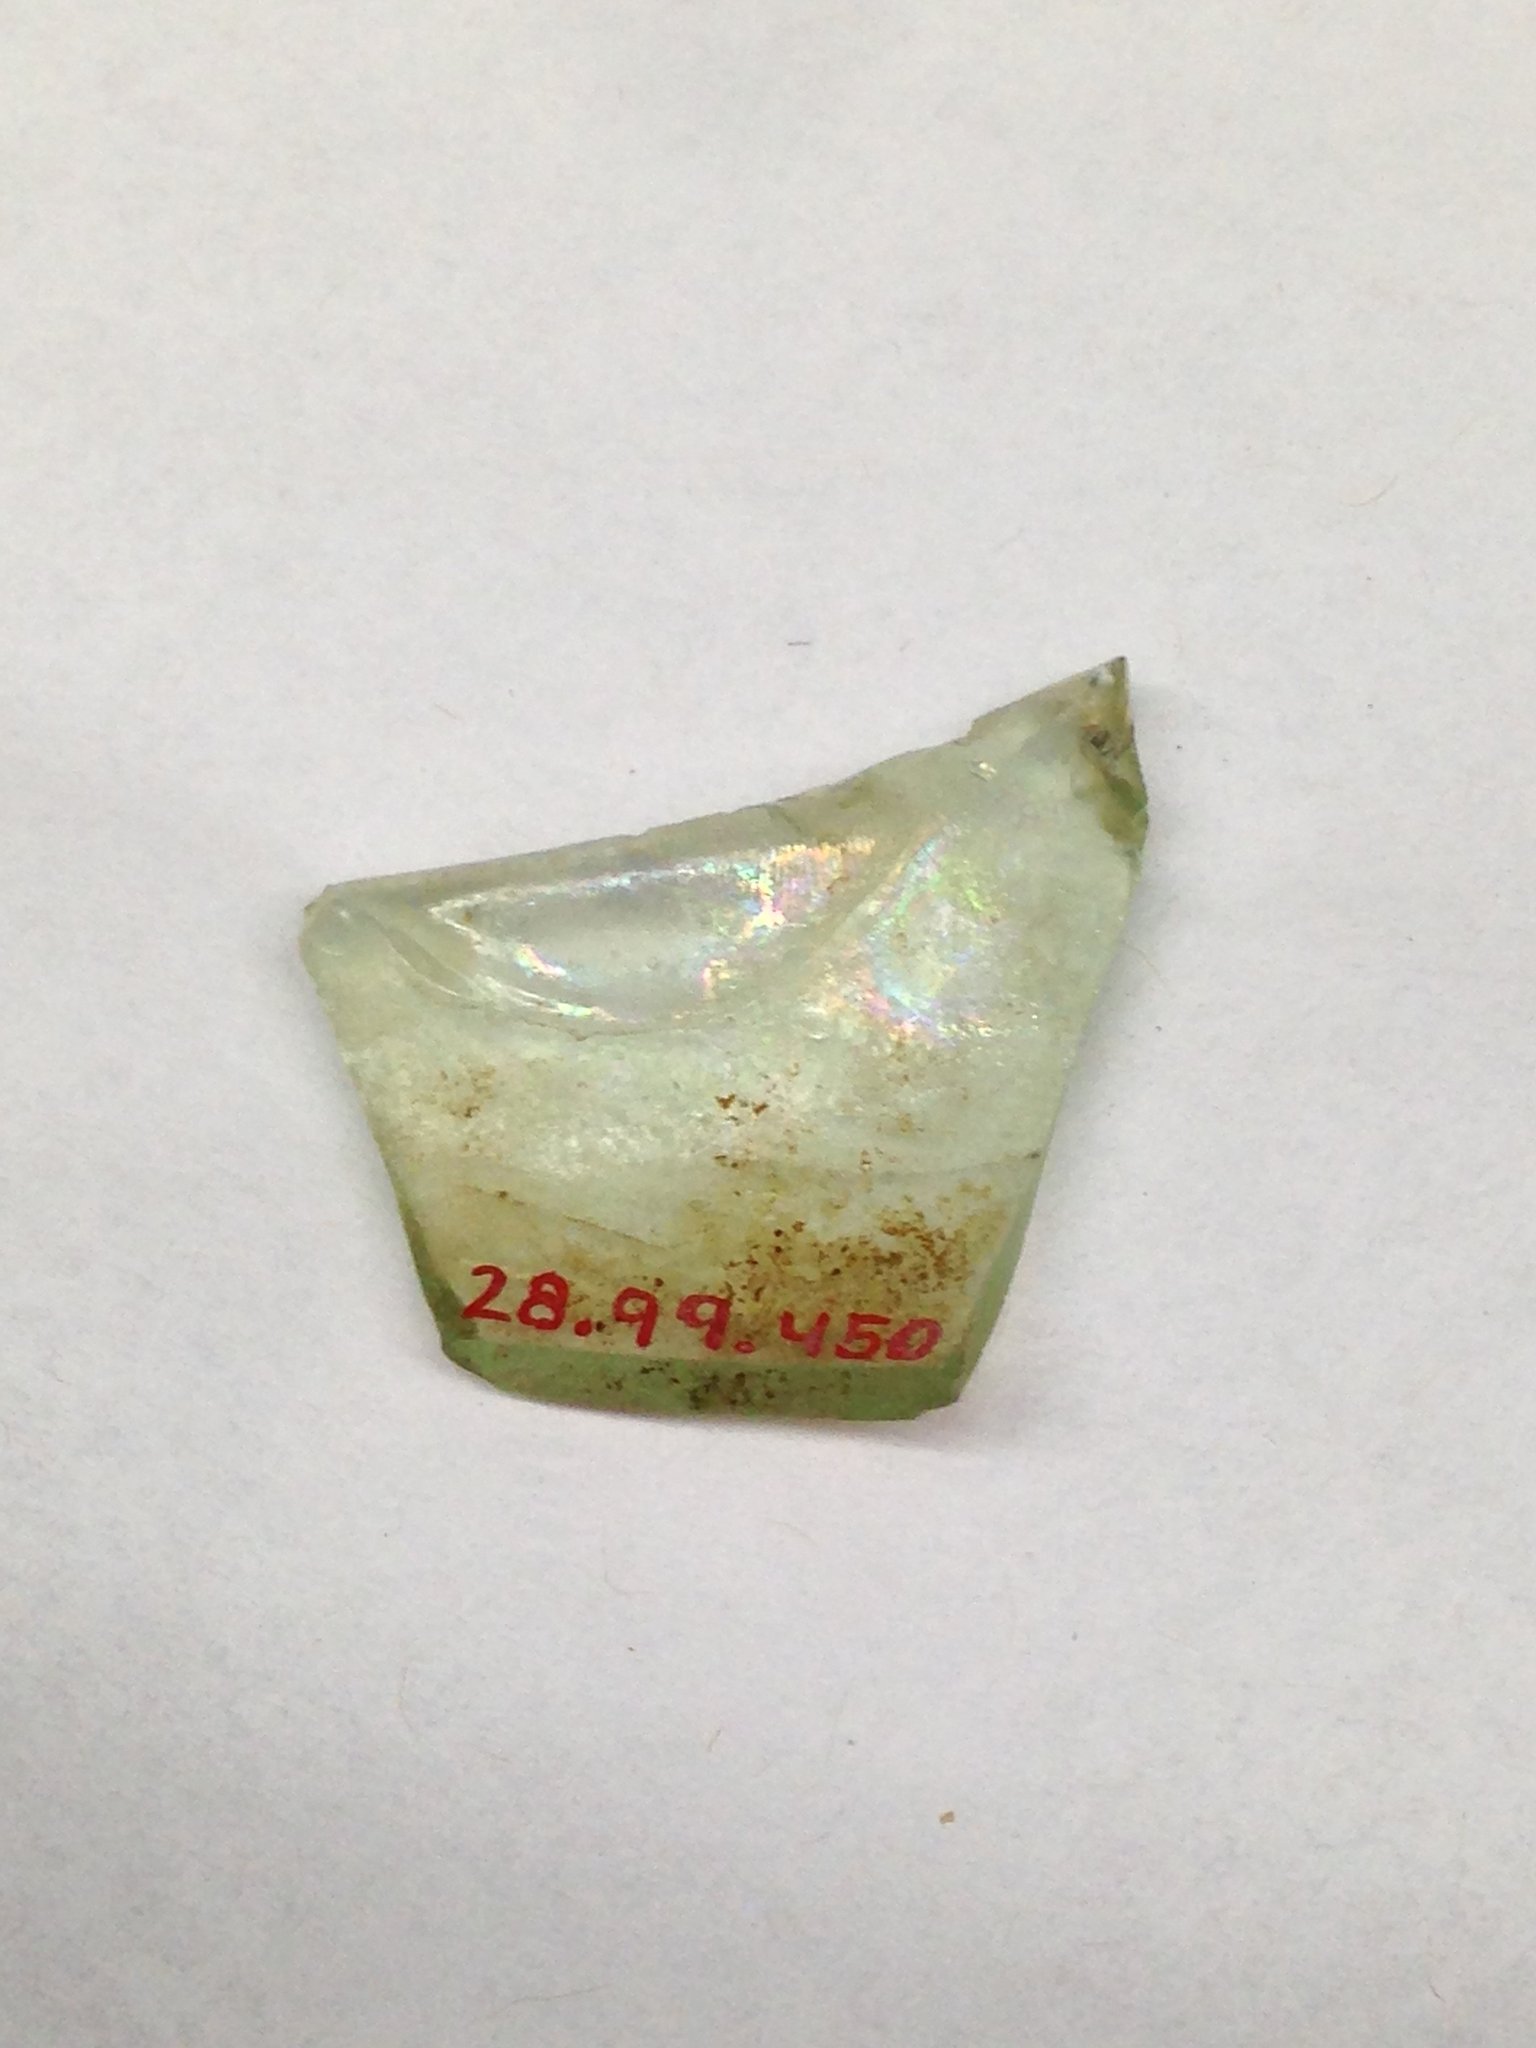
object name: fragment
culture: european or middle eastern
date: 1150-1250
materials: ceramic, glass